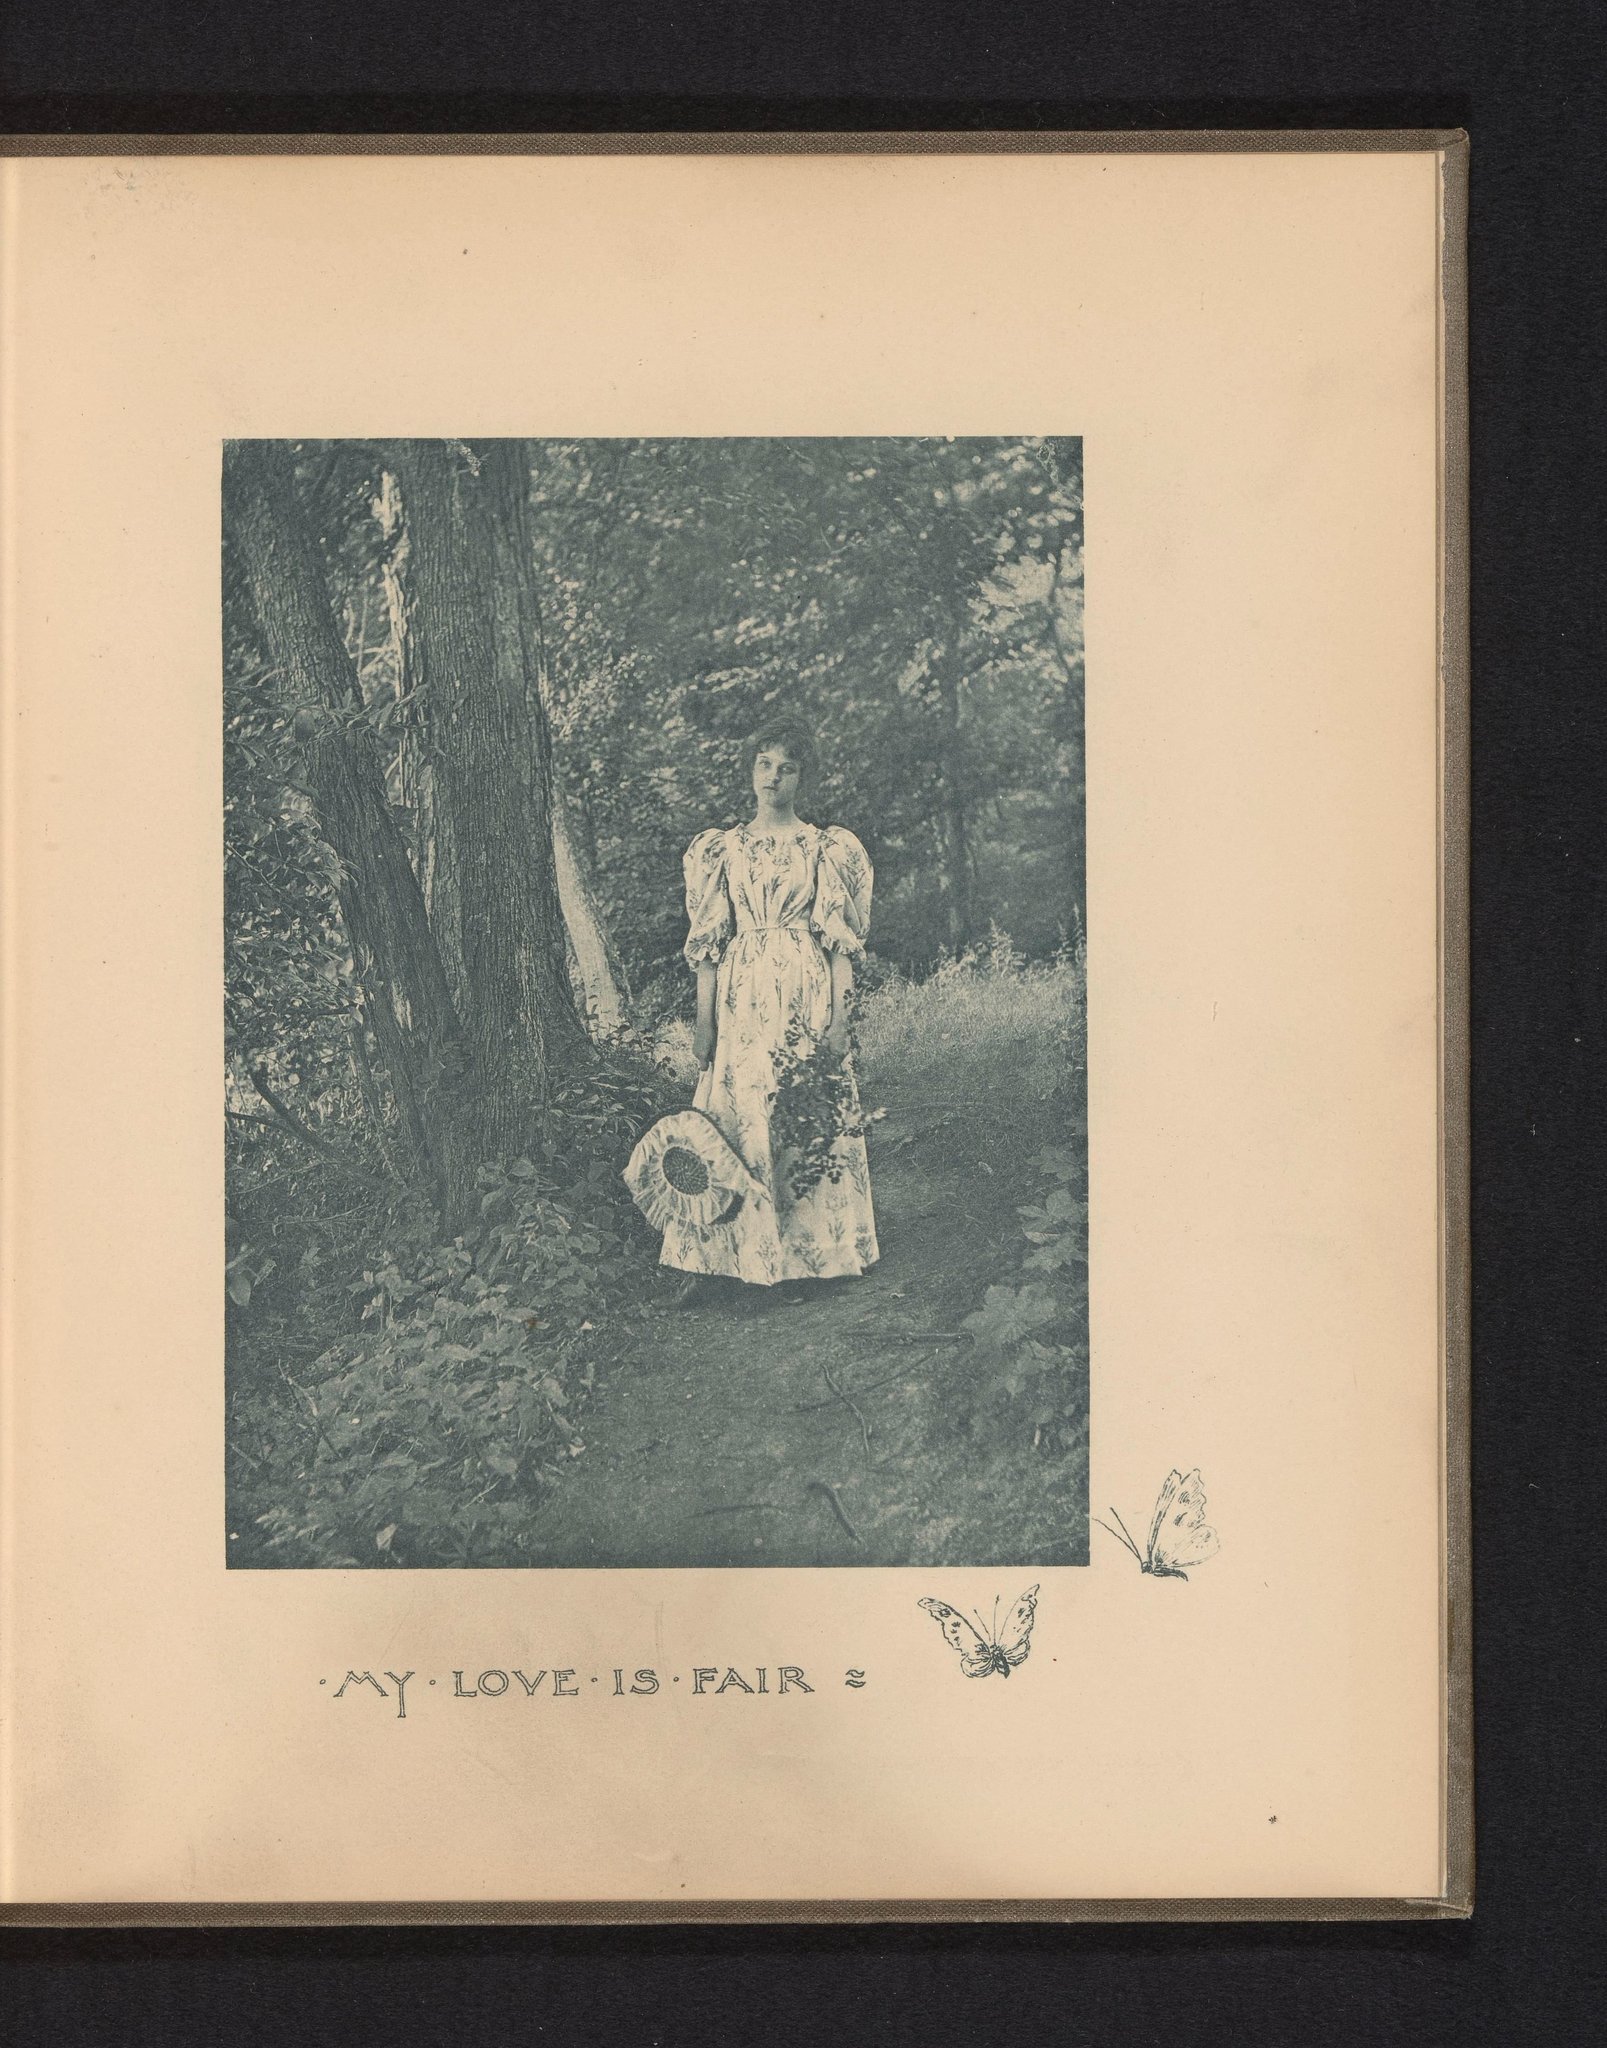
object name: page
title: Vrouw in een bos met takken en een hoed in haar handen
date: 1884-1894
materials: paper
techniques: photoaquatint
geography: united states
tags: adolescent, young woman, maiden, head-gear: hat, forest, wood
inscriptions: inscription: ‘My Love is Fair’